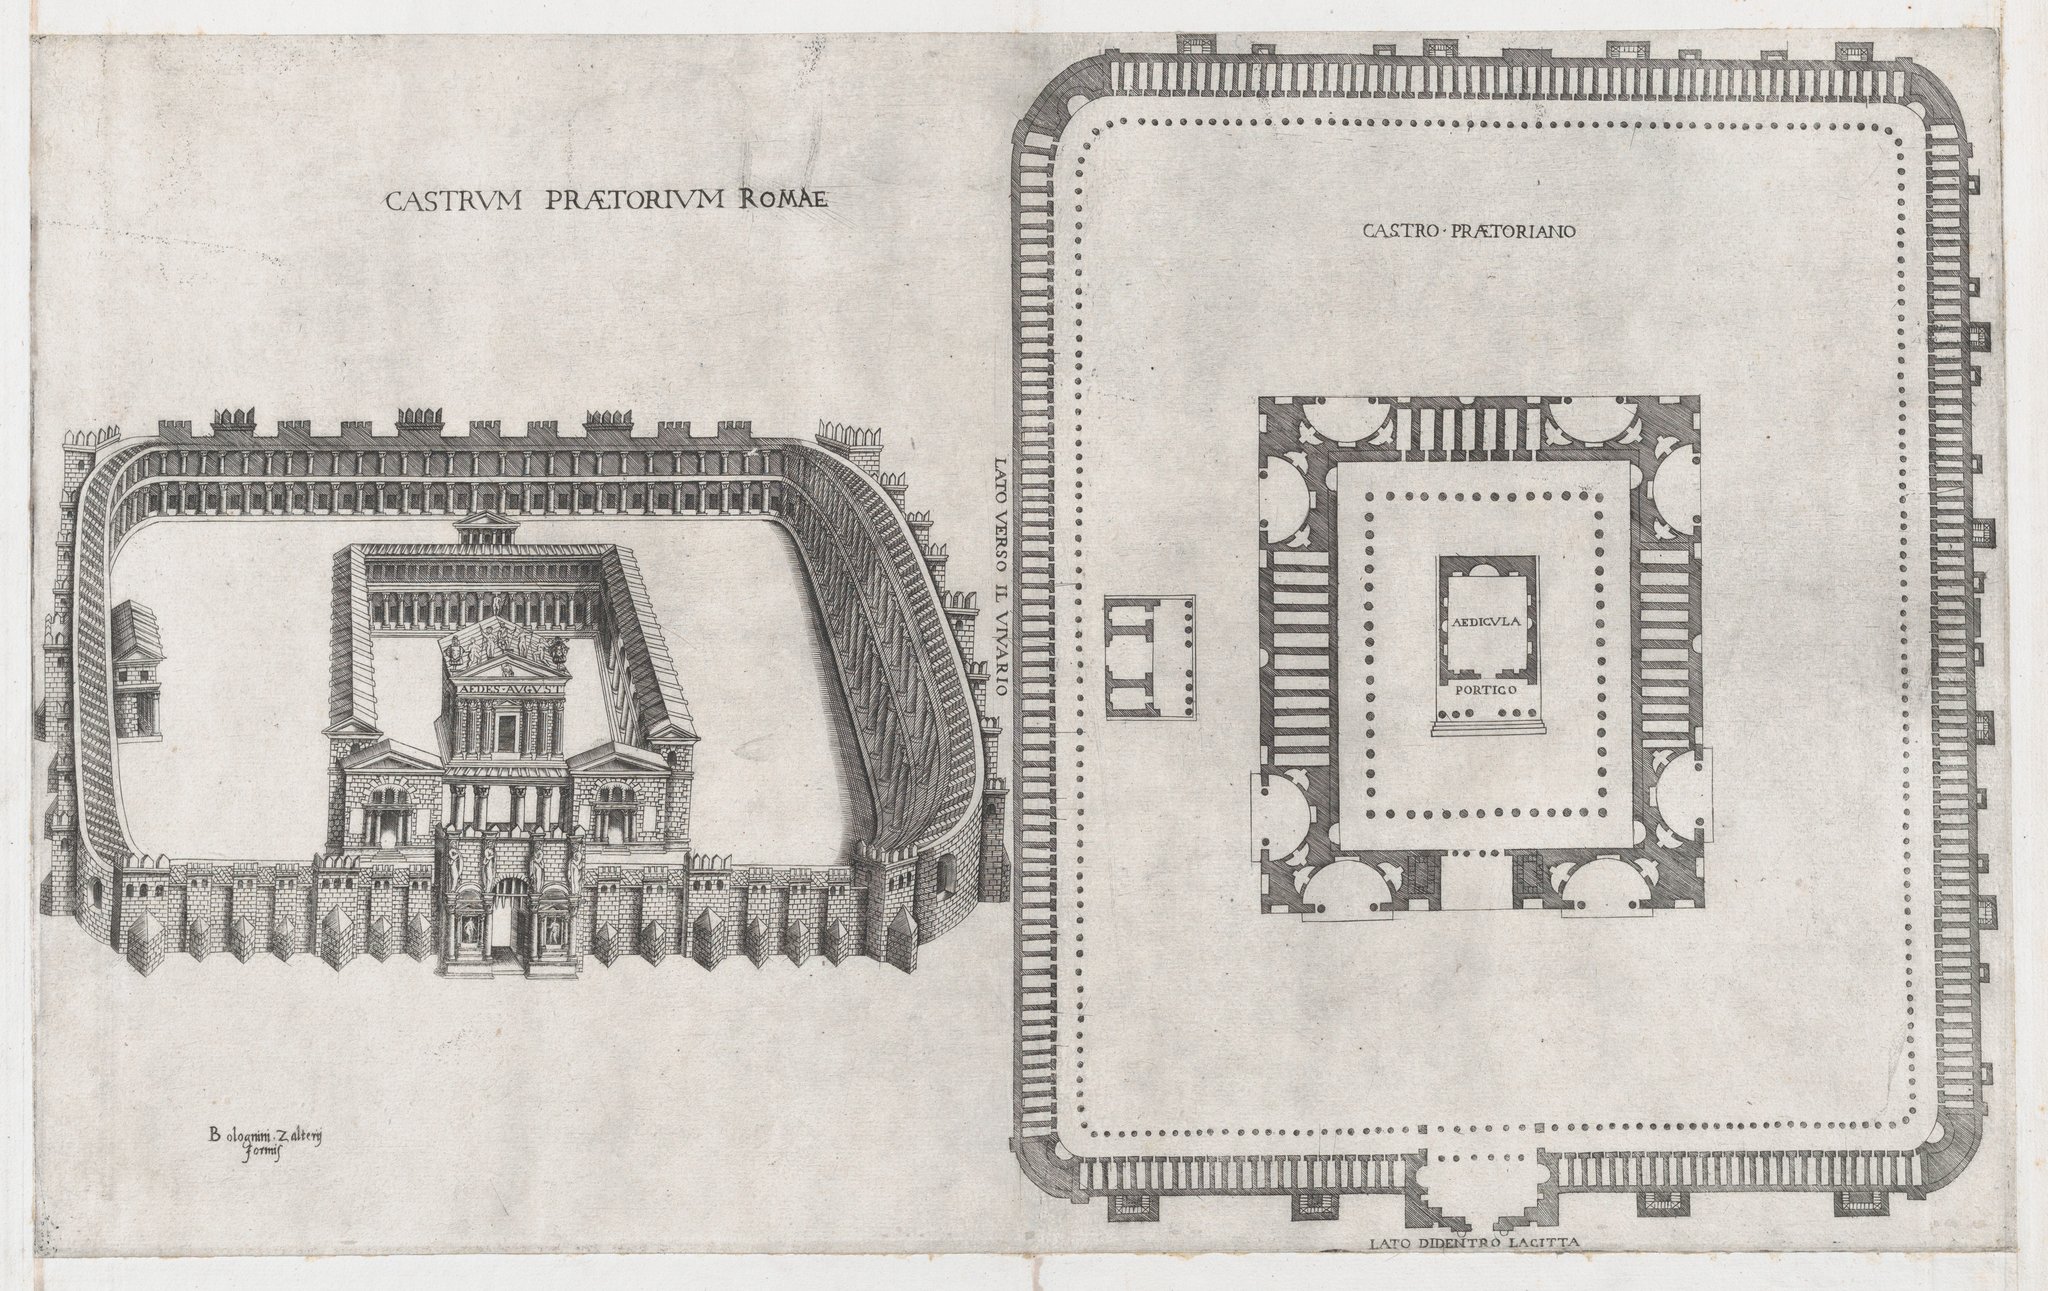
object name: print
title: Castrum, from "Speculum Romanae Magnificentiae"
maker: Anonymous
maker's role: artist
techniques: engraving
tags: architecture,rome